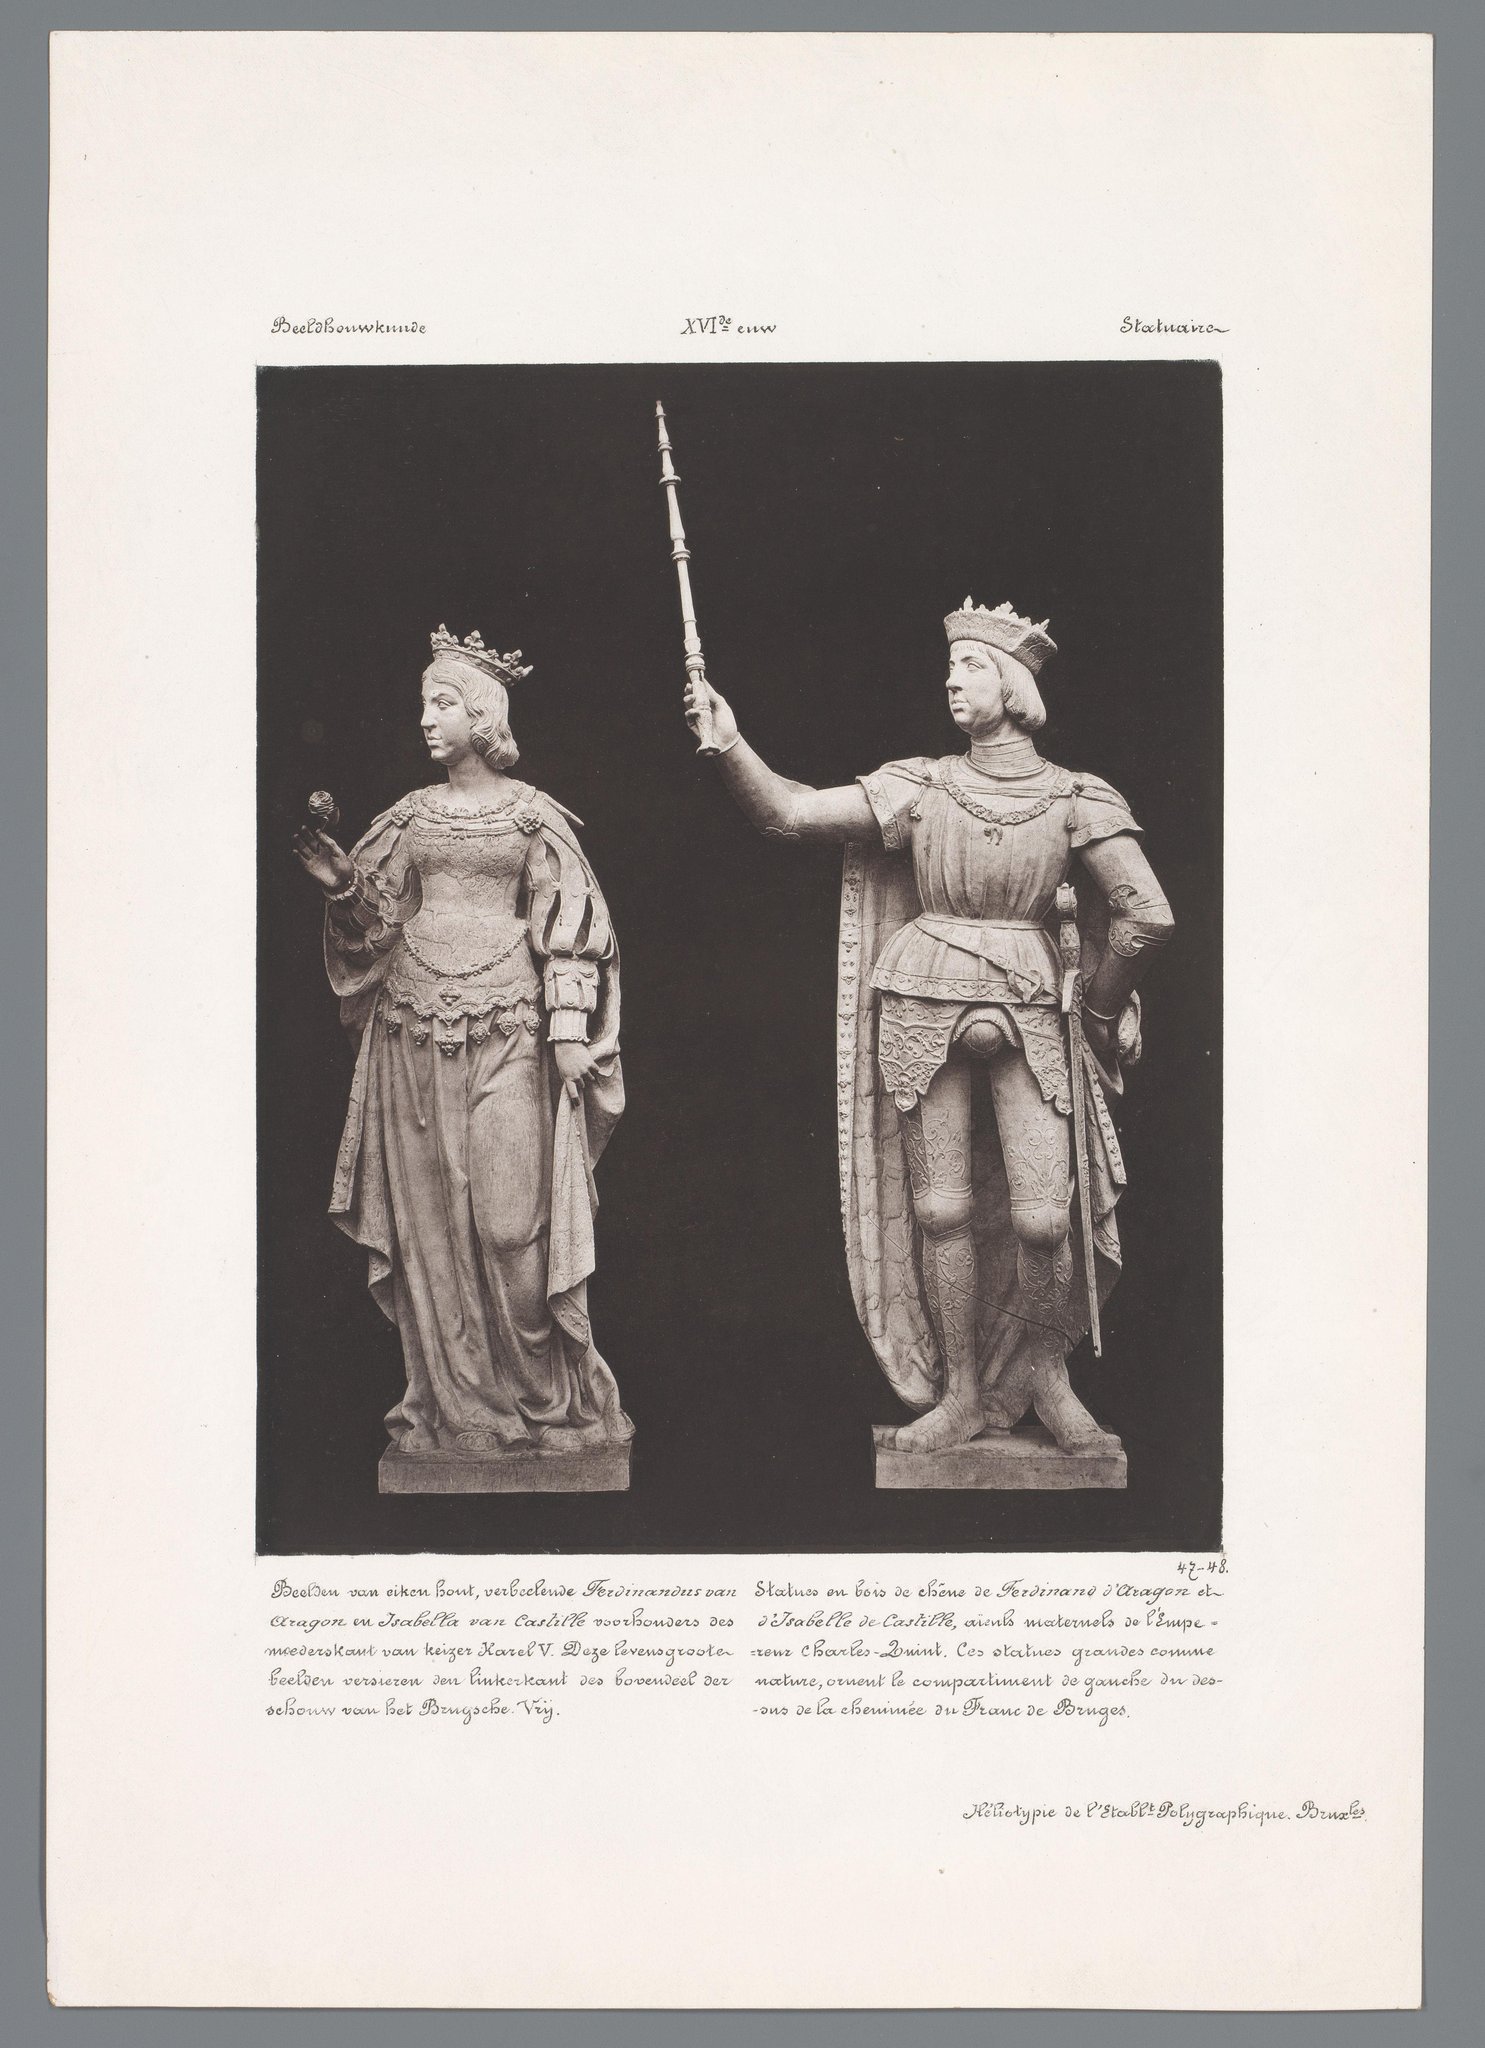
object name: reproduction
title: Reproductie van twee eikenhouten standbeelden van Isabella van Castille en Ferdinand van Aragon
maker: alexandre de blochouse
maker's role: fotograaf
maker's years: 1821-1901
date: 1880-1900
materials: paper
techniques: photoaquatint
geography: brussels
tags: ruler, sovereign, sculpture